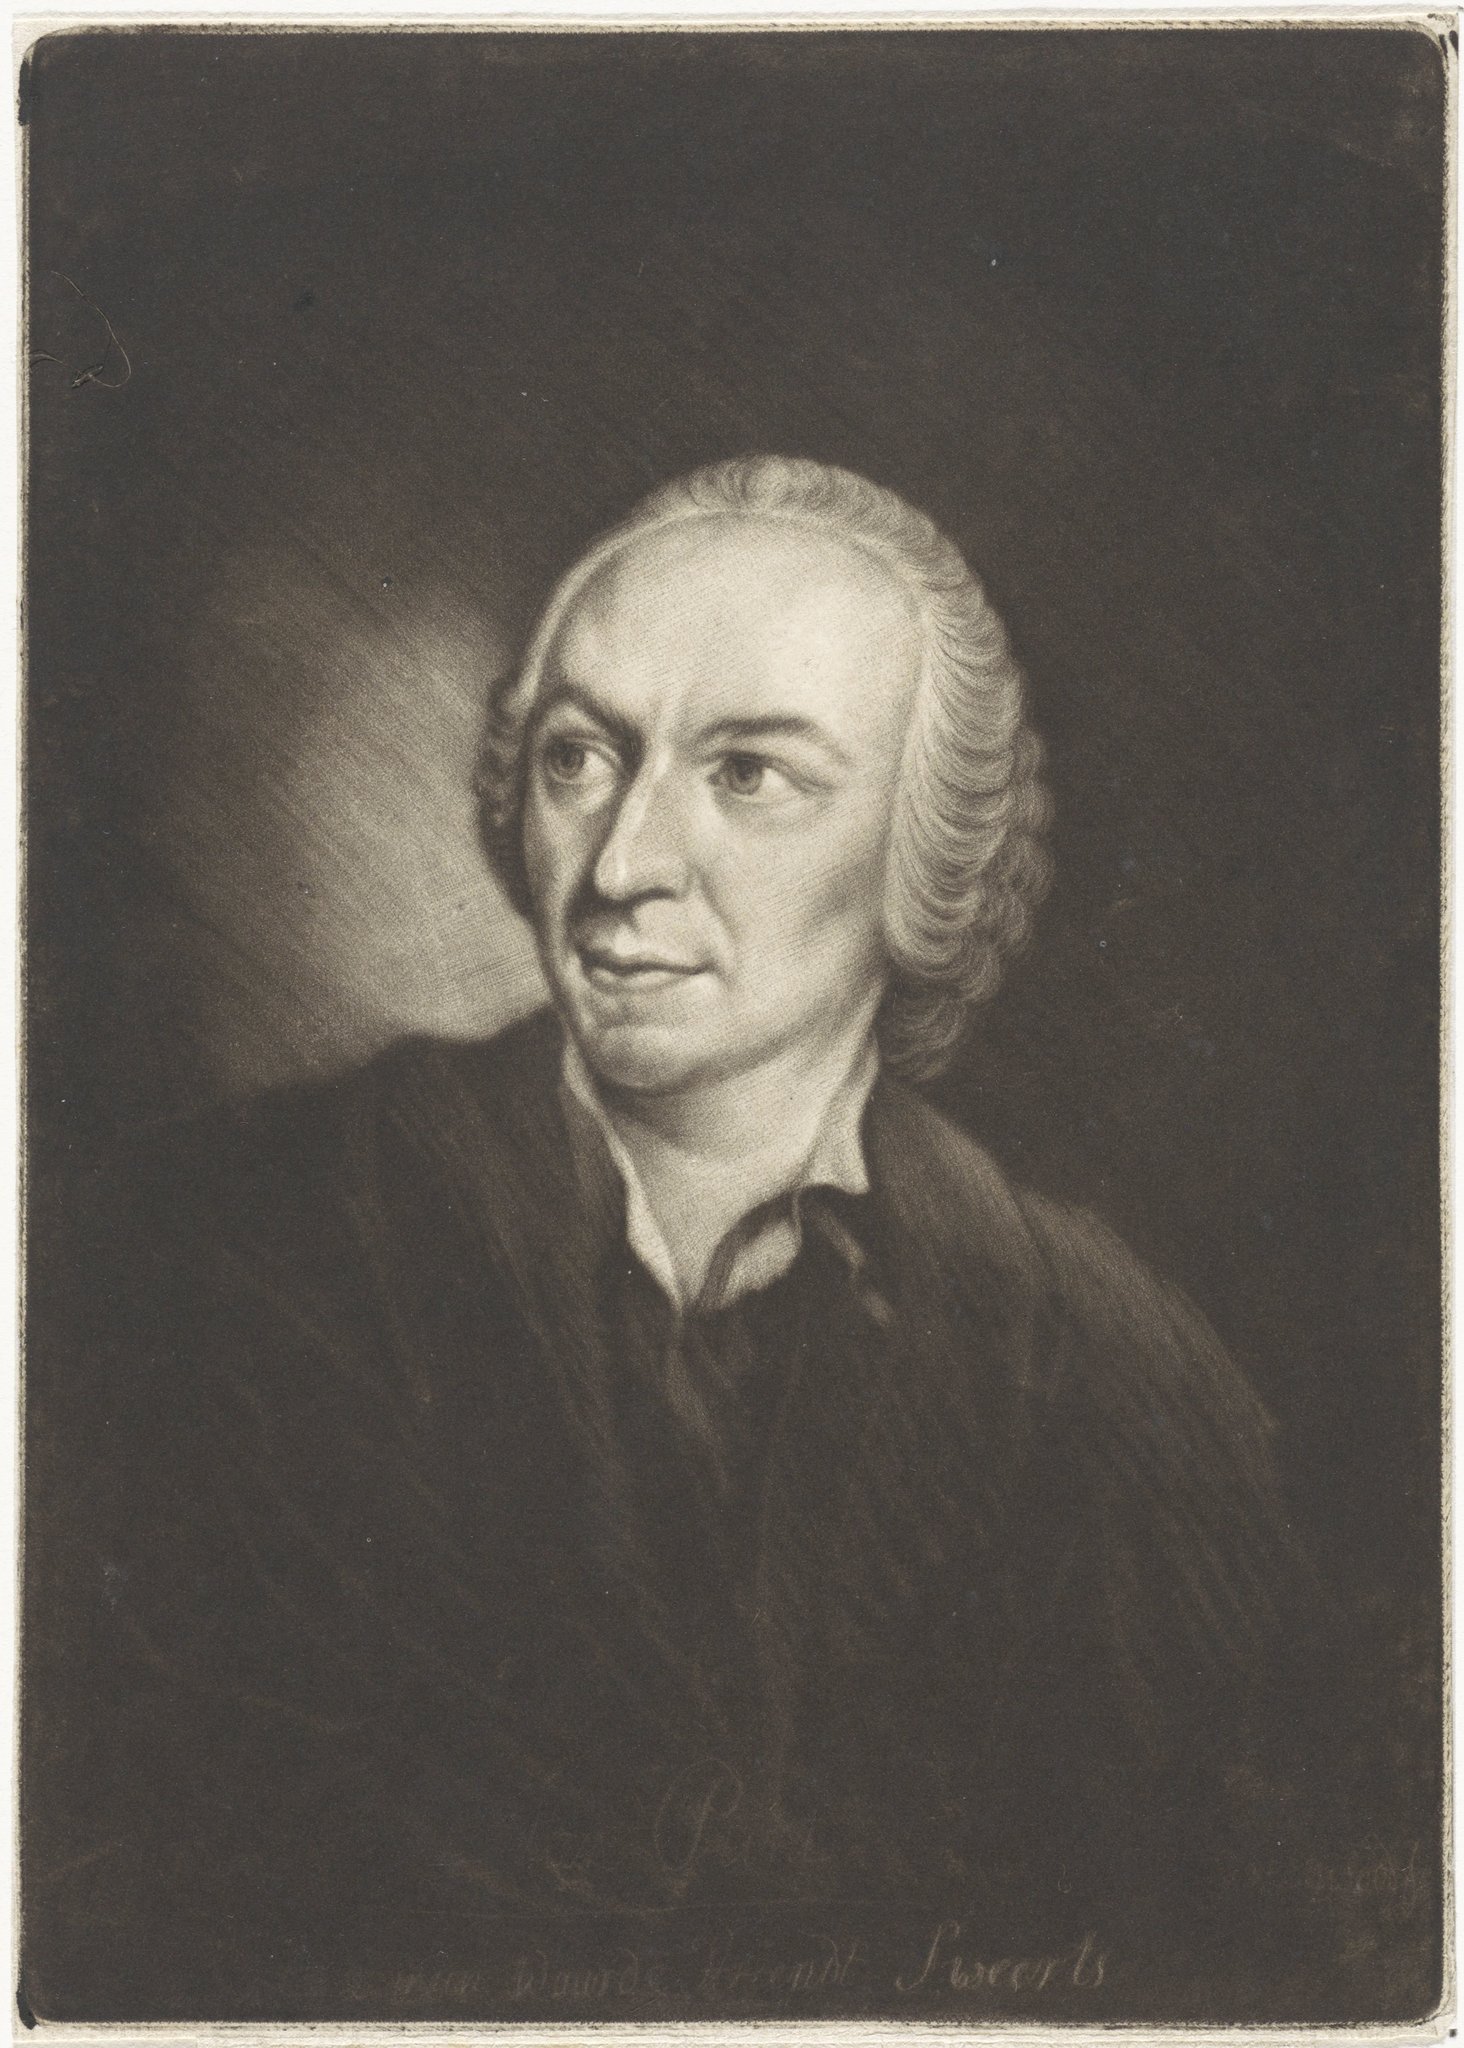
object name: print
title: Portret van Jan Punt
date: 1739-1792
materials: paper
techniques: mezzotint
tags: amsterdam, jan punt, wig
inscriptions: collector's mark: Lugt 2228, inscription: ‘Aan myn Vriend Sweerts / [...]’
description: De prentmaker, tekenaar en uitgever Jan Punt.